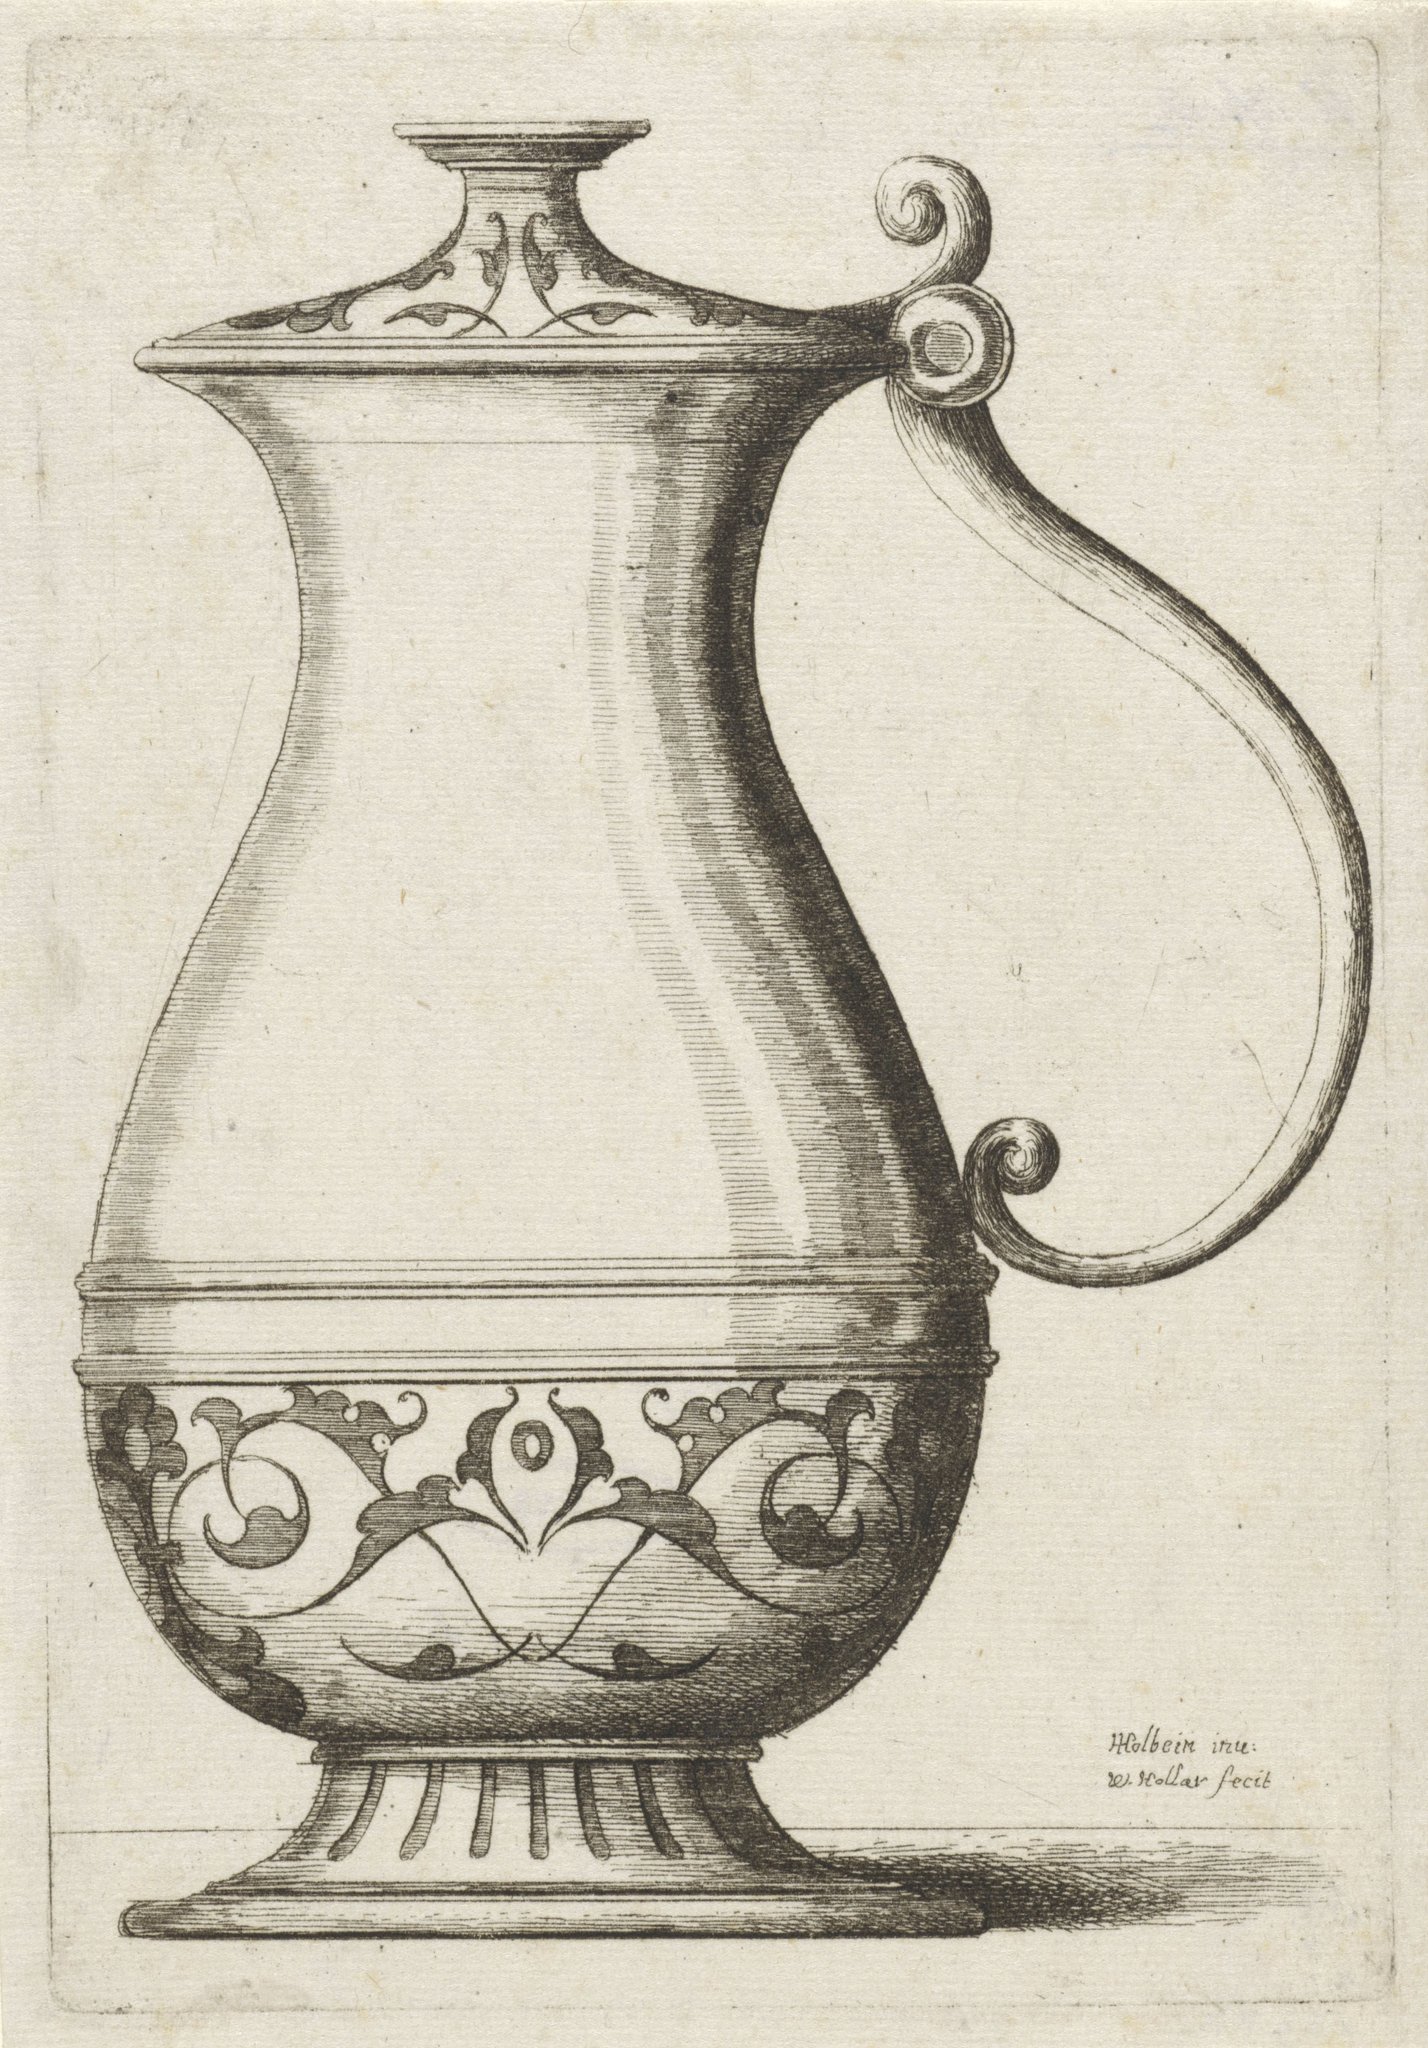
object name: print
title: Ornamentele schalen en kannen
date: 1645-1649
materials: paper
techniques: etching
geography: antwerp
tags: laid table: table-ware, table-decoration, etc.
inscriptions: collector's mark: Lugt 2228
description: Prent maakt deel uit van een tiendelige serie met ornamentele schalen en kannen.